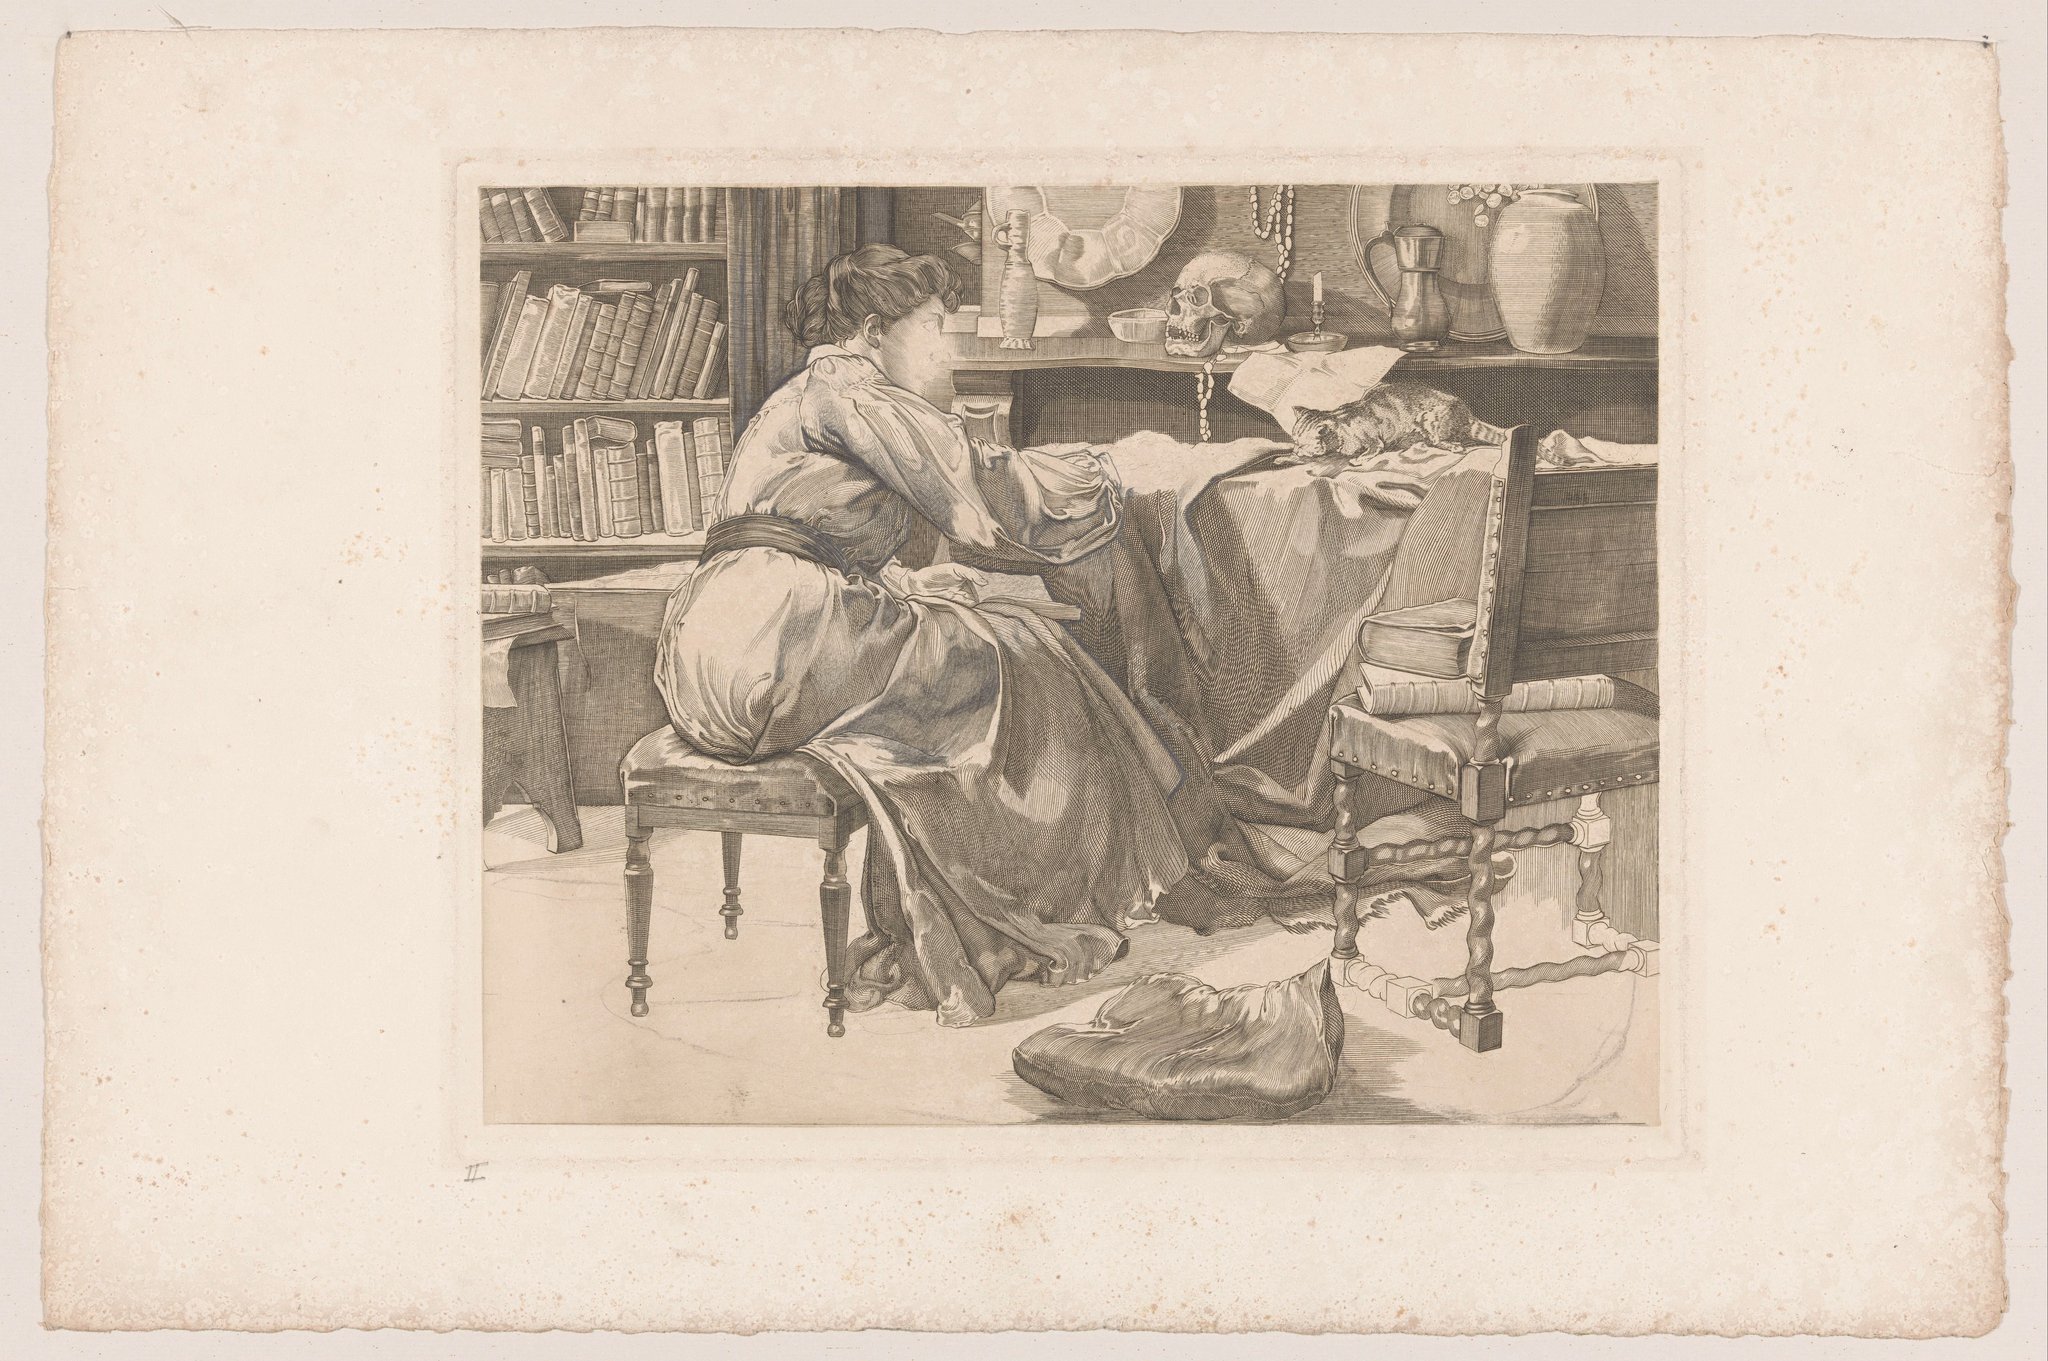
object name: print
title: Vrouw en kat in atelier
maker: johannes josephus aarts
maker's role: draughtsman, print maker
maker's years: 1871-1934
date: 1881-1934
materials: chalk, paper, pencil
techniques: engraving, intaglio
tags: cat, (human) skull, workshop, studio ~ painter, book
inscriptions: collector's mark: Lugt 2228, collector's mark: Lugt 2166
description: Een vrouw in een jurk zit op een kruk aan een tafel met daarop een kat. Ze houdt een opengeslagen boek in haar linkerhand vast. Op de achtergrond een boekenkast en een dressoir met vazen, een schedel en een kaars in een kandelaar. Tegen de muur twee schalen.